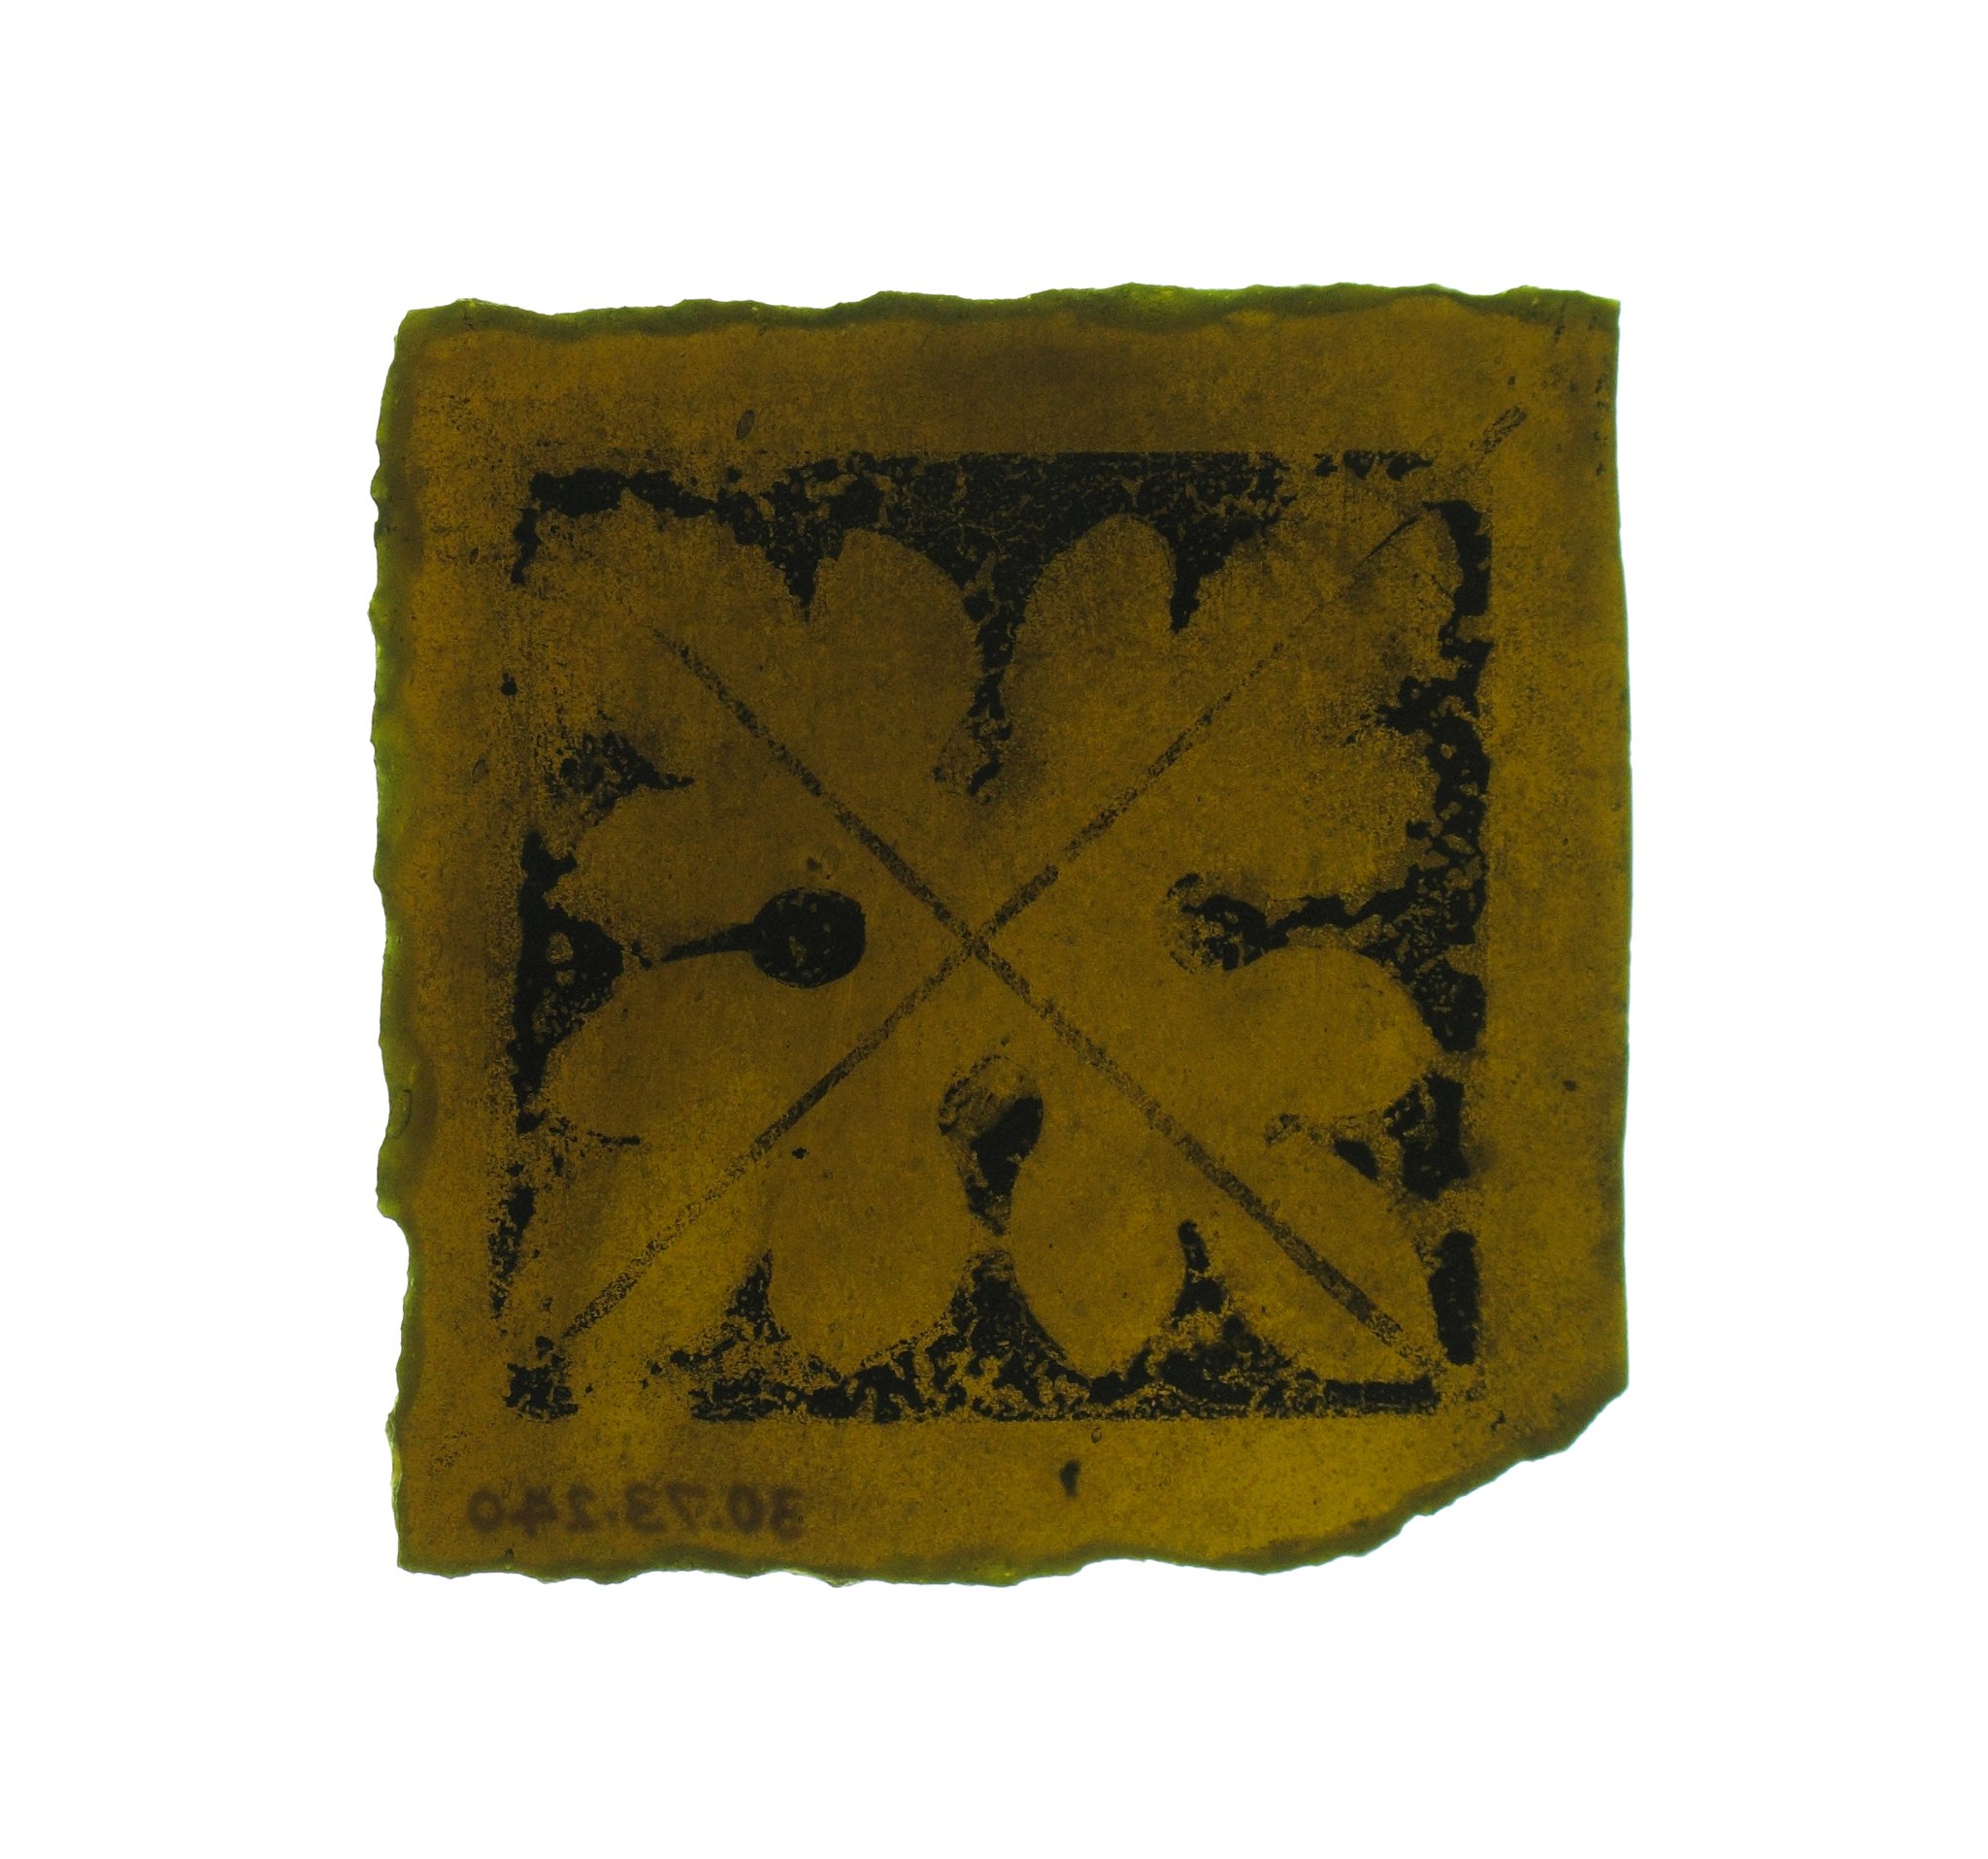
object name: fragment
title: Glass Fragment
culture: european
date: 1301-1400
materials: glass, metal